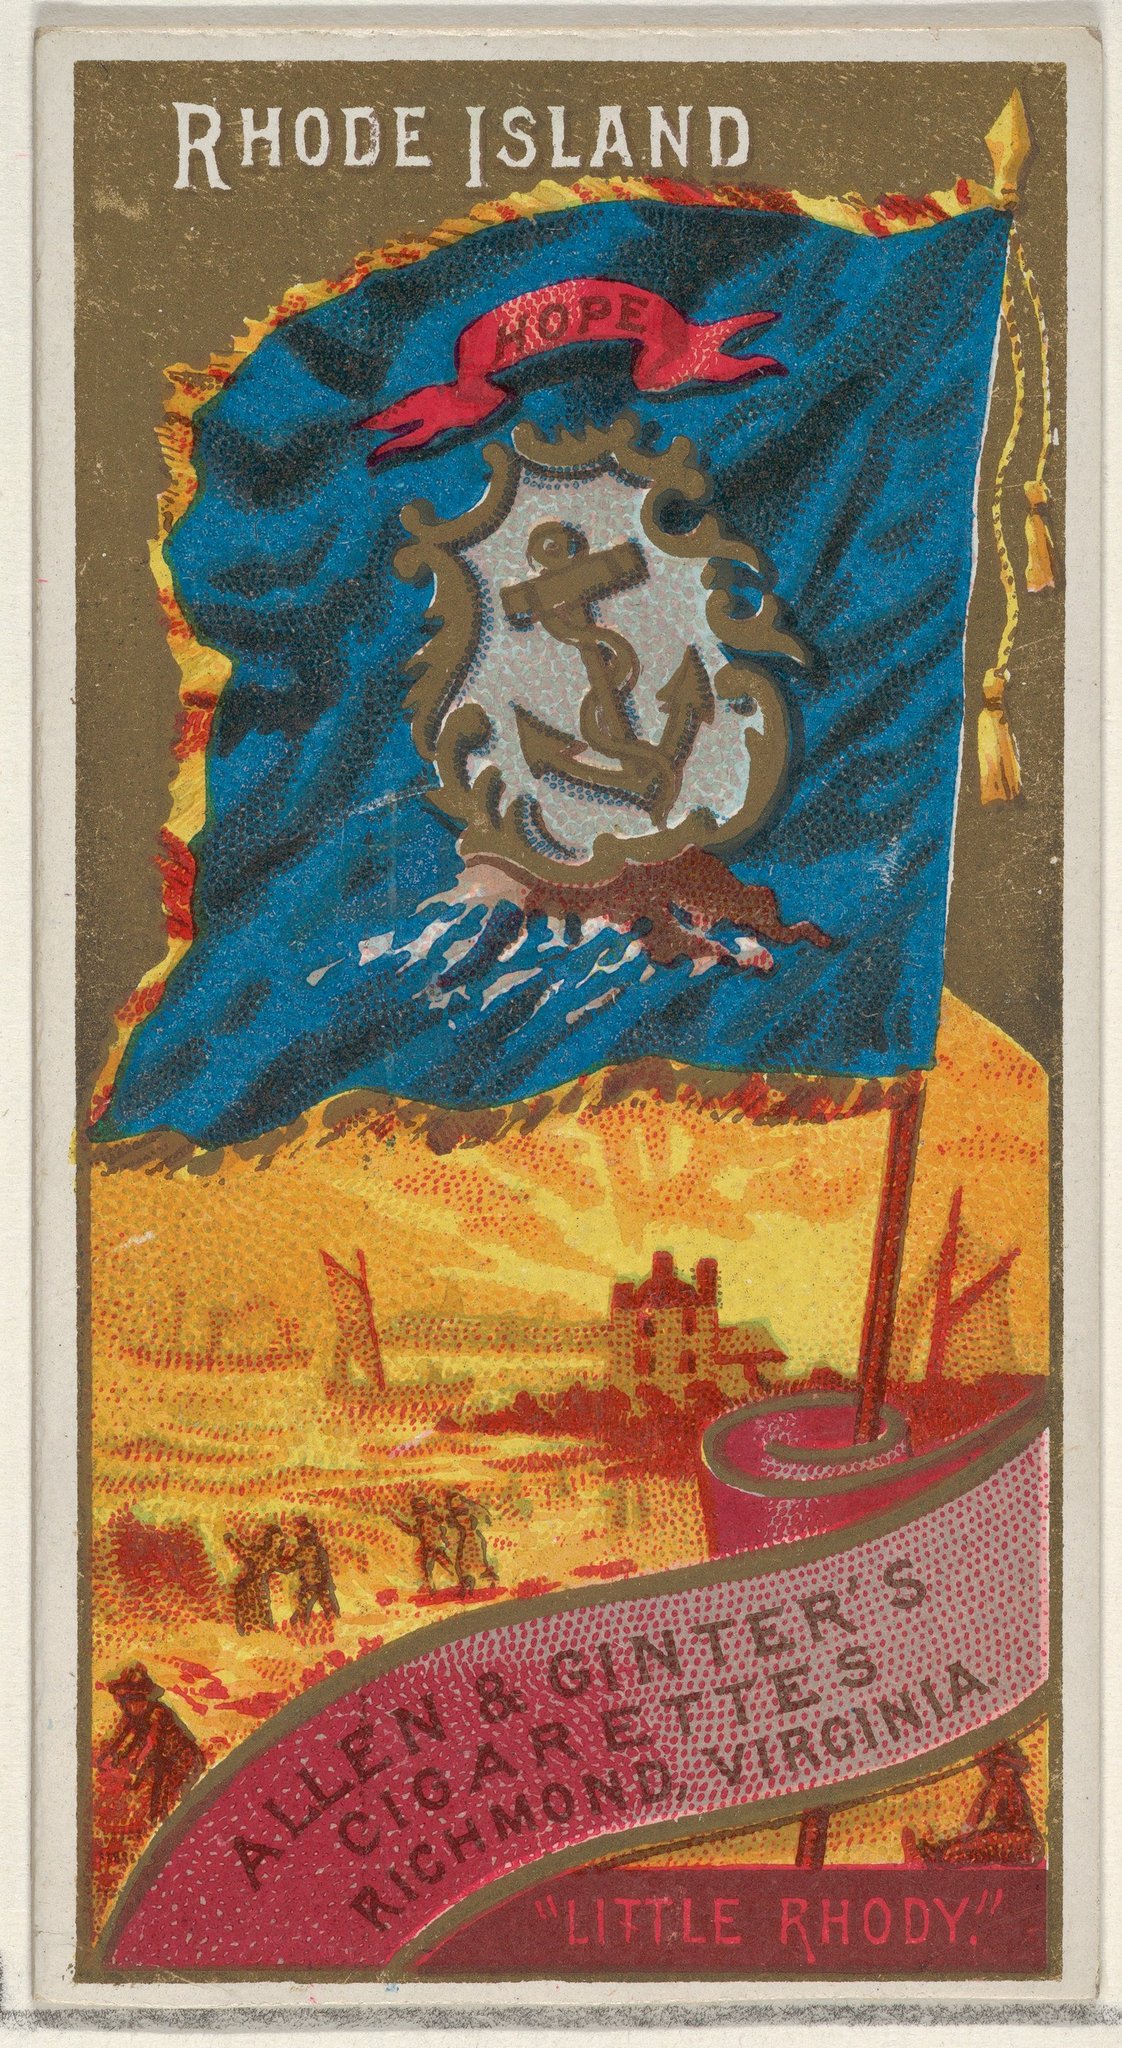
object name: print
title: Rhode Island, from Flags of the States and Territories (N11) for Allen & Ginter Cigarettes Brands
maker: allen & ginter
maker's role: publisher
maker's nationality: american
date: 1888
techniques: color lithograph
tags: flags